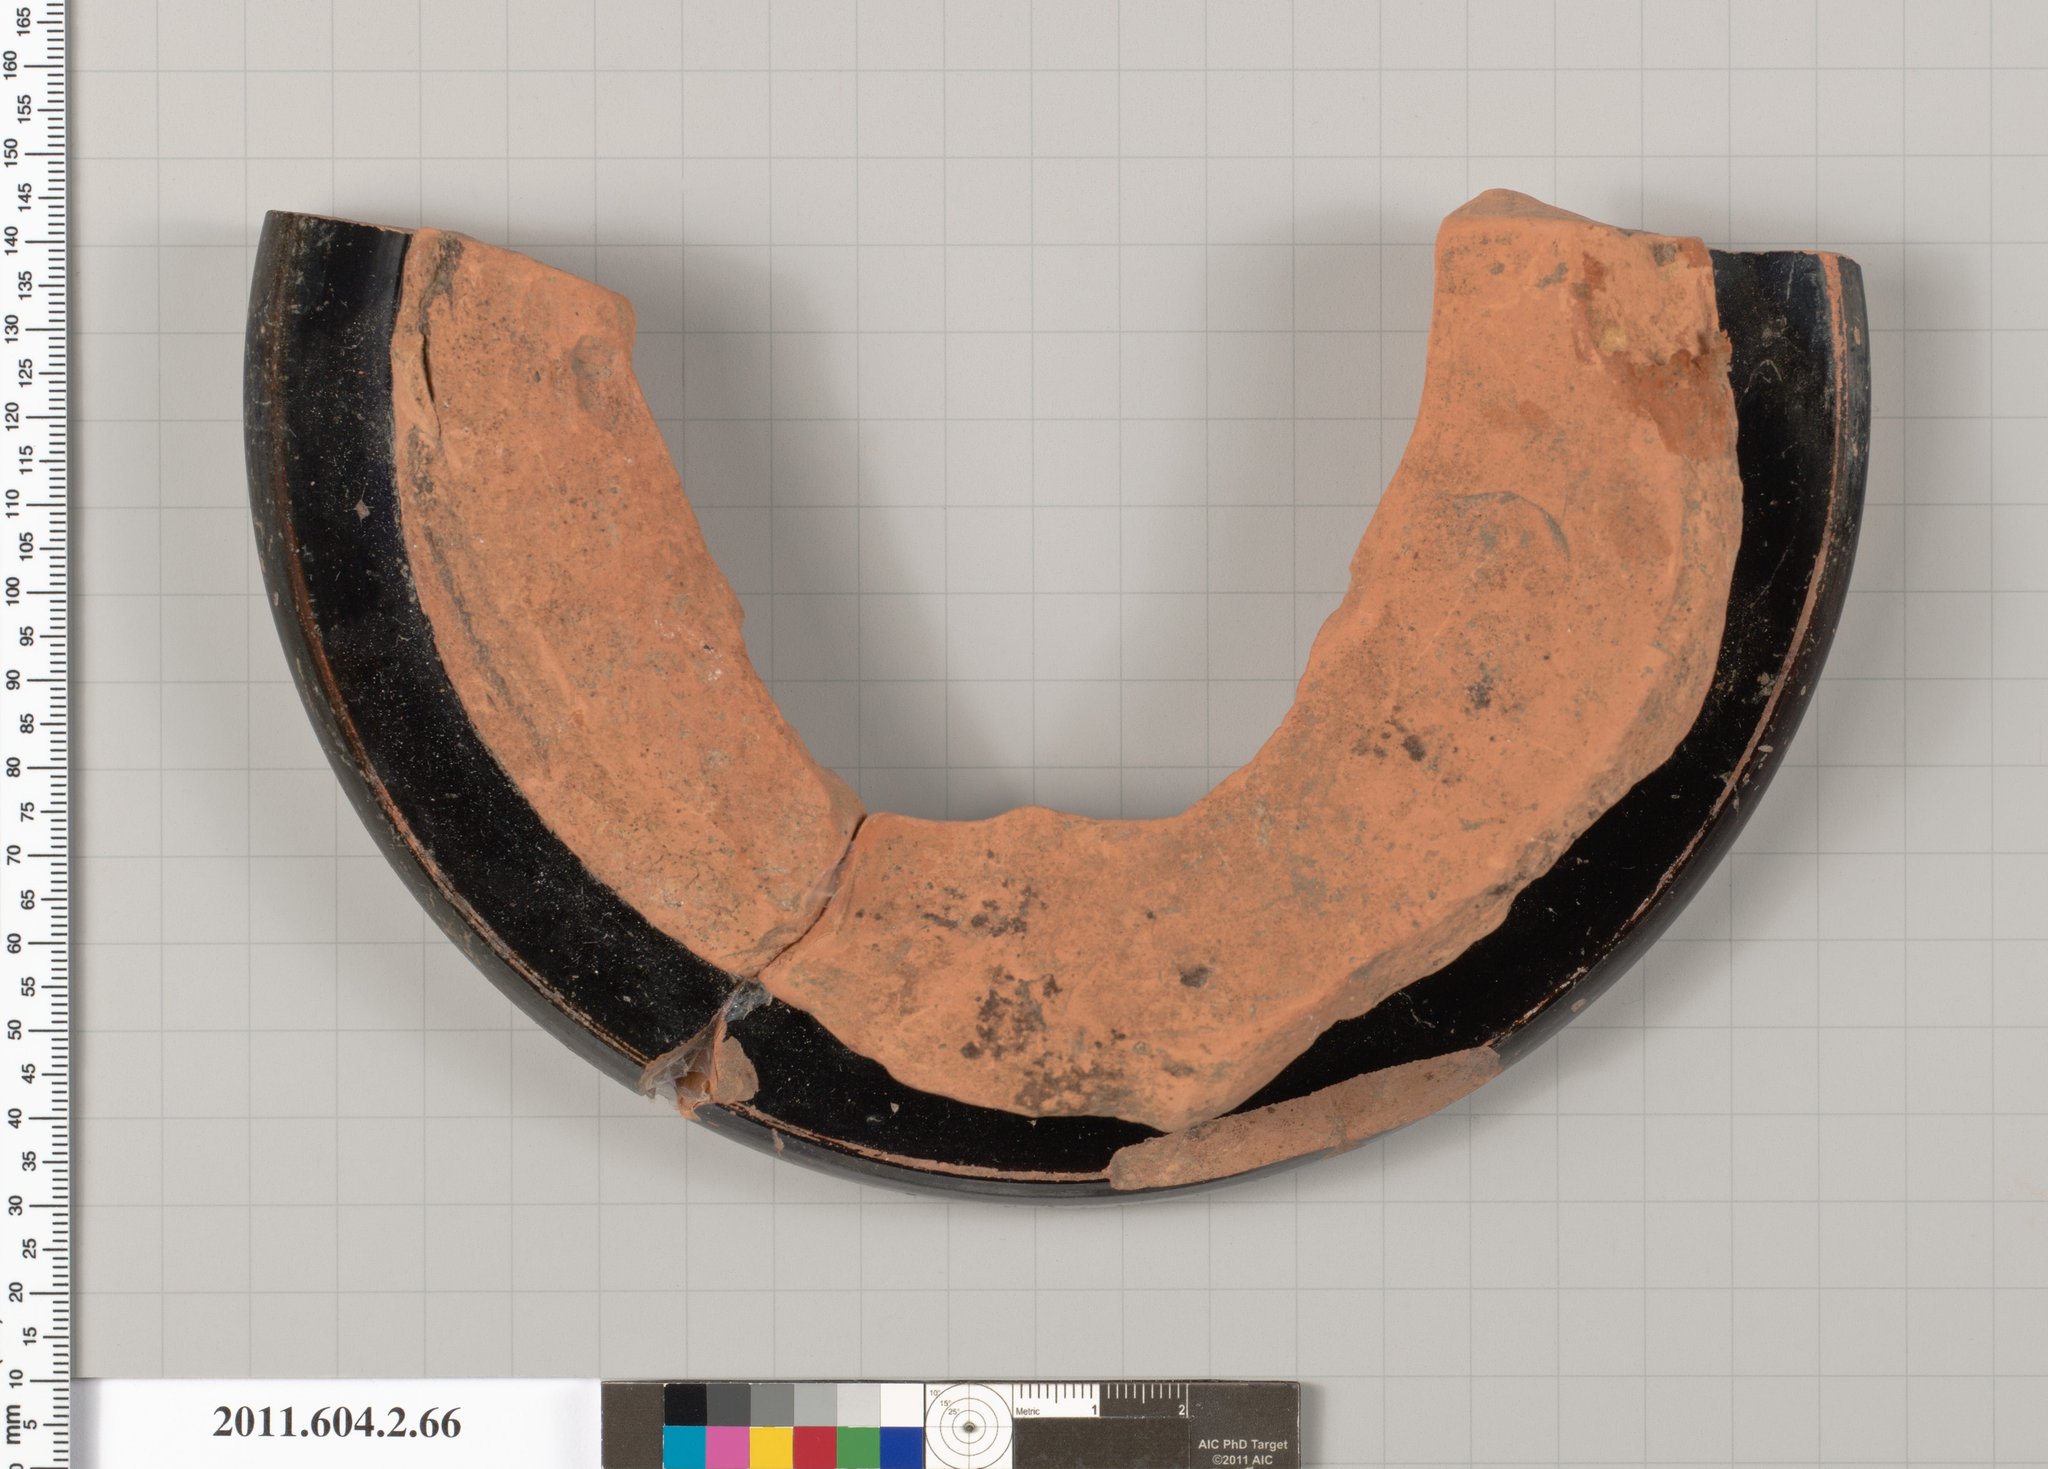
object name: amphora fragment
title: Terracotta fragment of an amphora (jar)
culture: greek, attic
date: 534-468 BCE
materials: terracotta